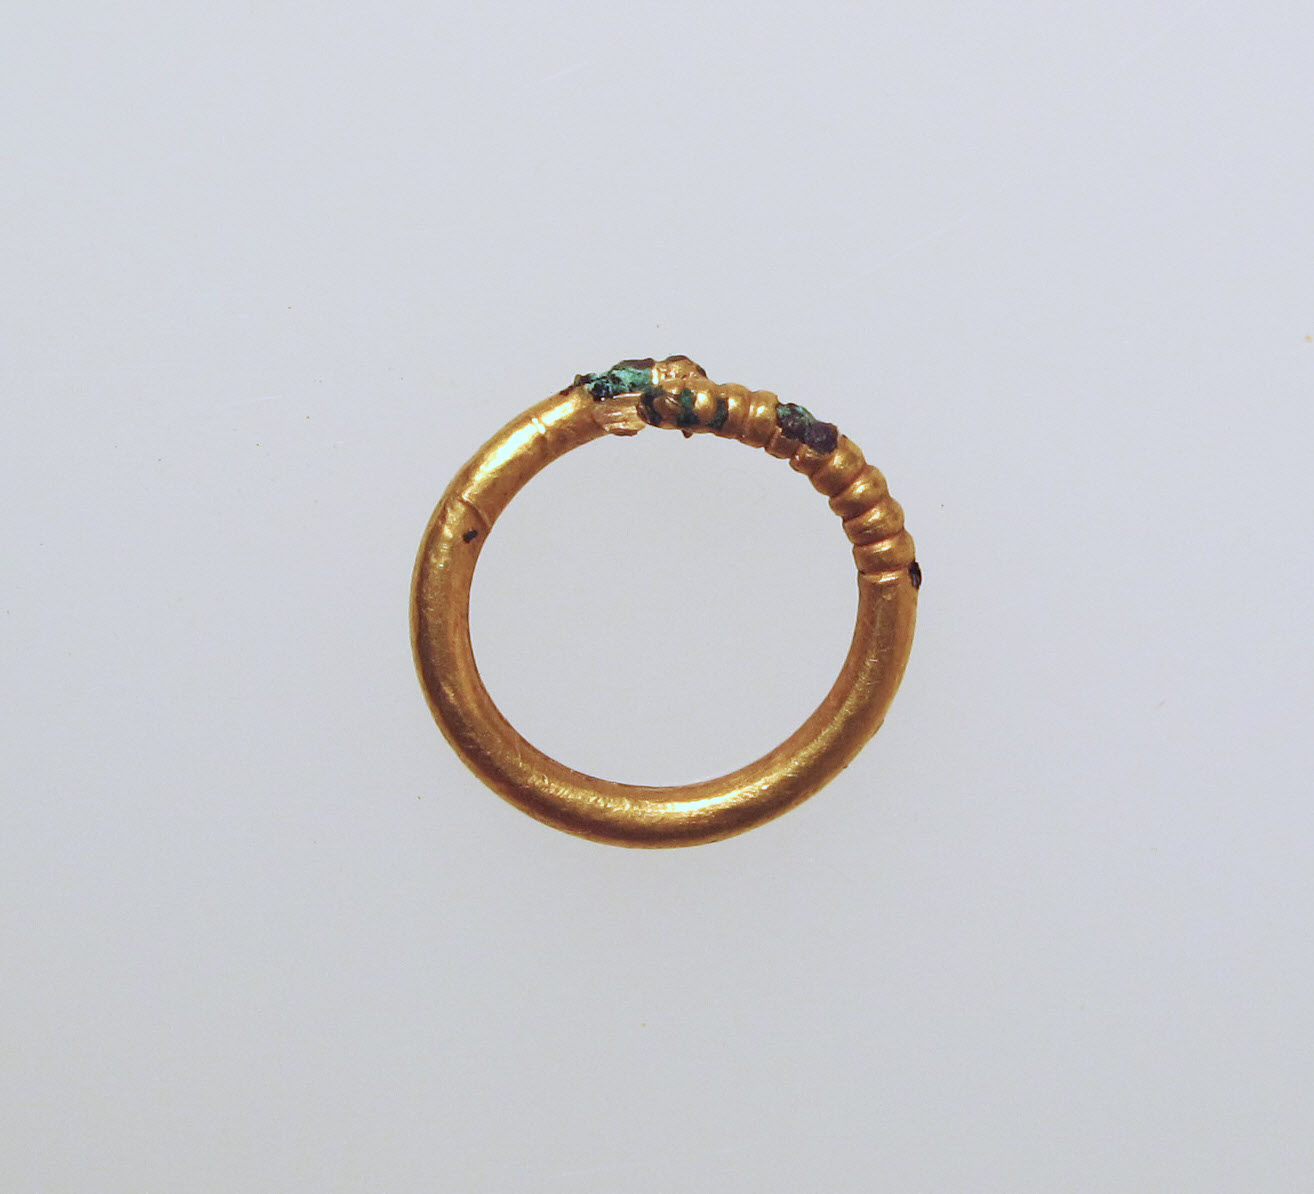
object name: earring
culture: cypriot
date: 3900 BCE-100 CE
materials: bronze, gold